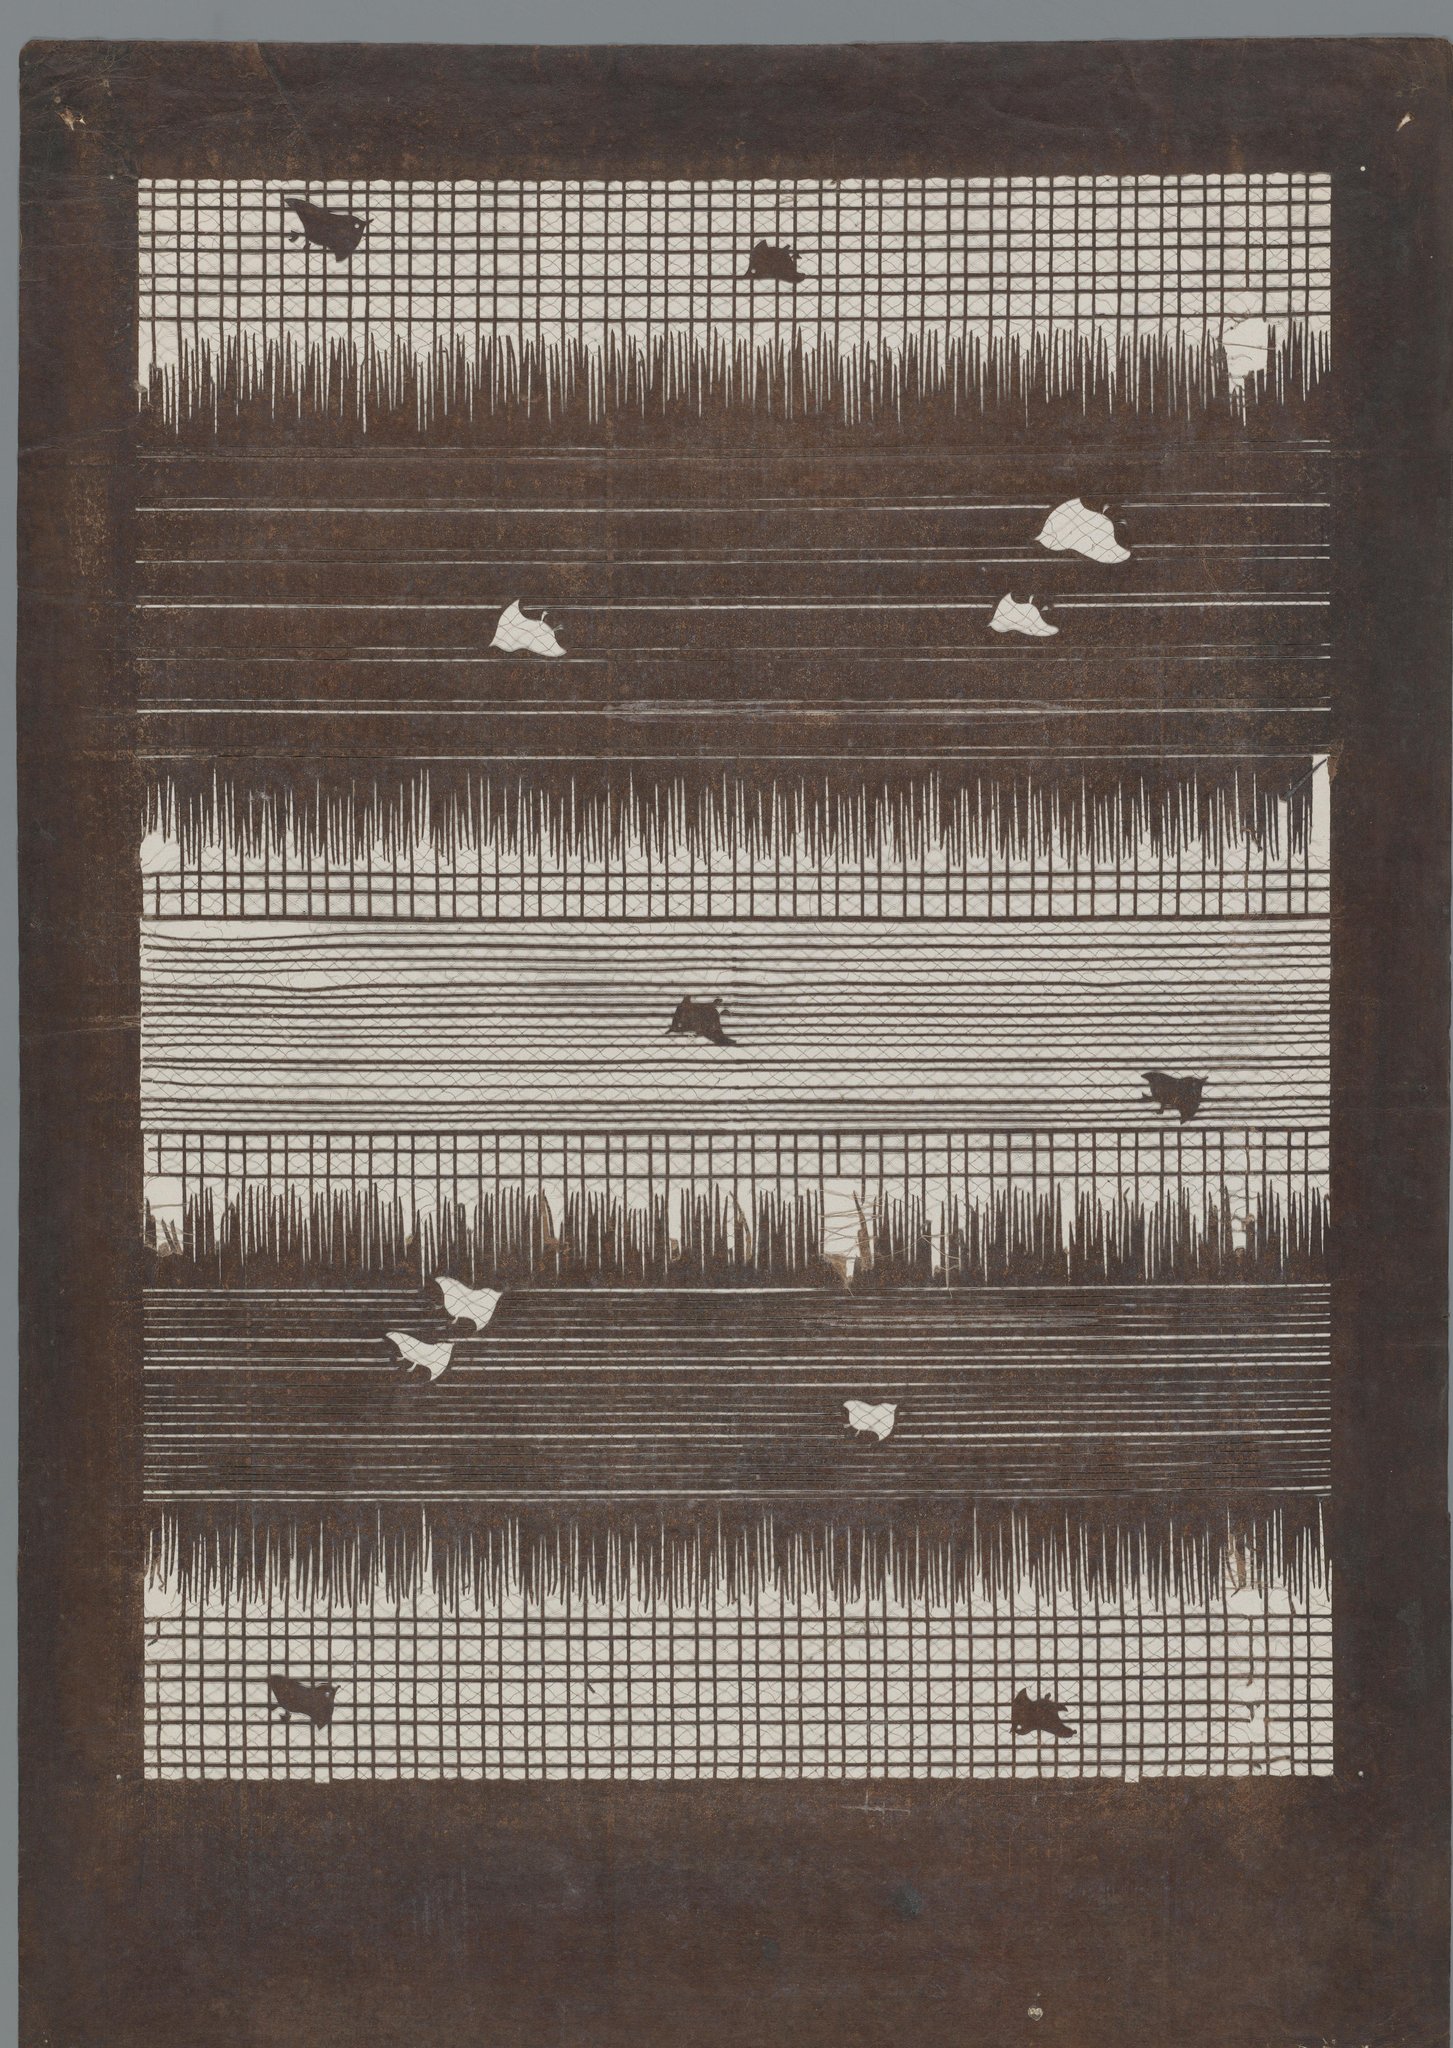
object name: katagami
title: Sjabloon met vallende bladeren en lijnen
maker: Anonymous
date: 1800-1909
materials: paper, silk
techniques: cutting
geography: japan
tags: foliage, tendrils, branches ~ ornament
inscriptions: stamp: ‘Afgeschreven W...’, label: ‘1/5’, label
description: Japanse sjabloon (katagami) met een patroon van enkele vallende bladeren tegen een achtergrond van rasterwerk en lijnen.